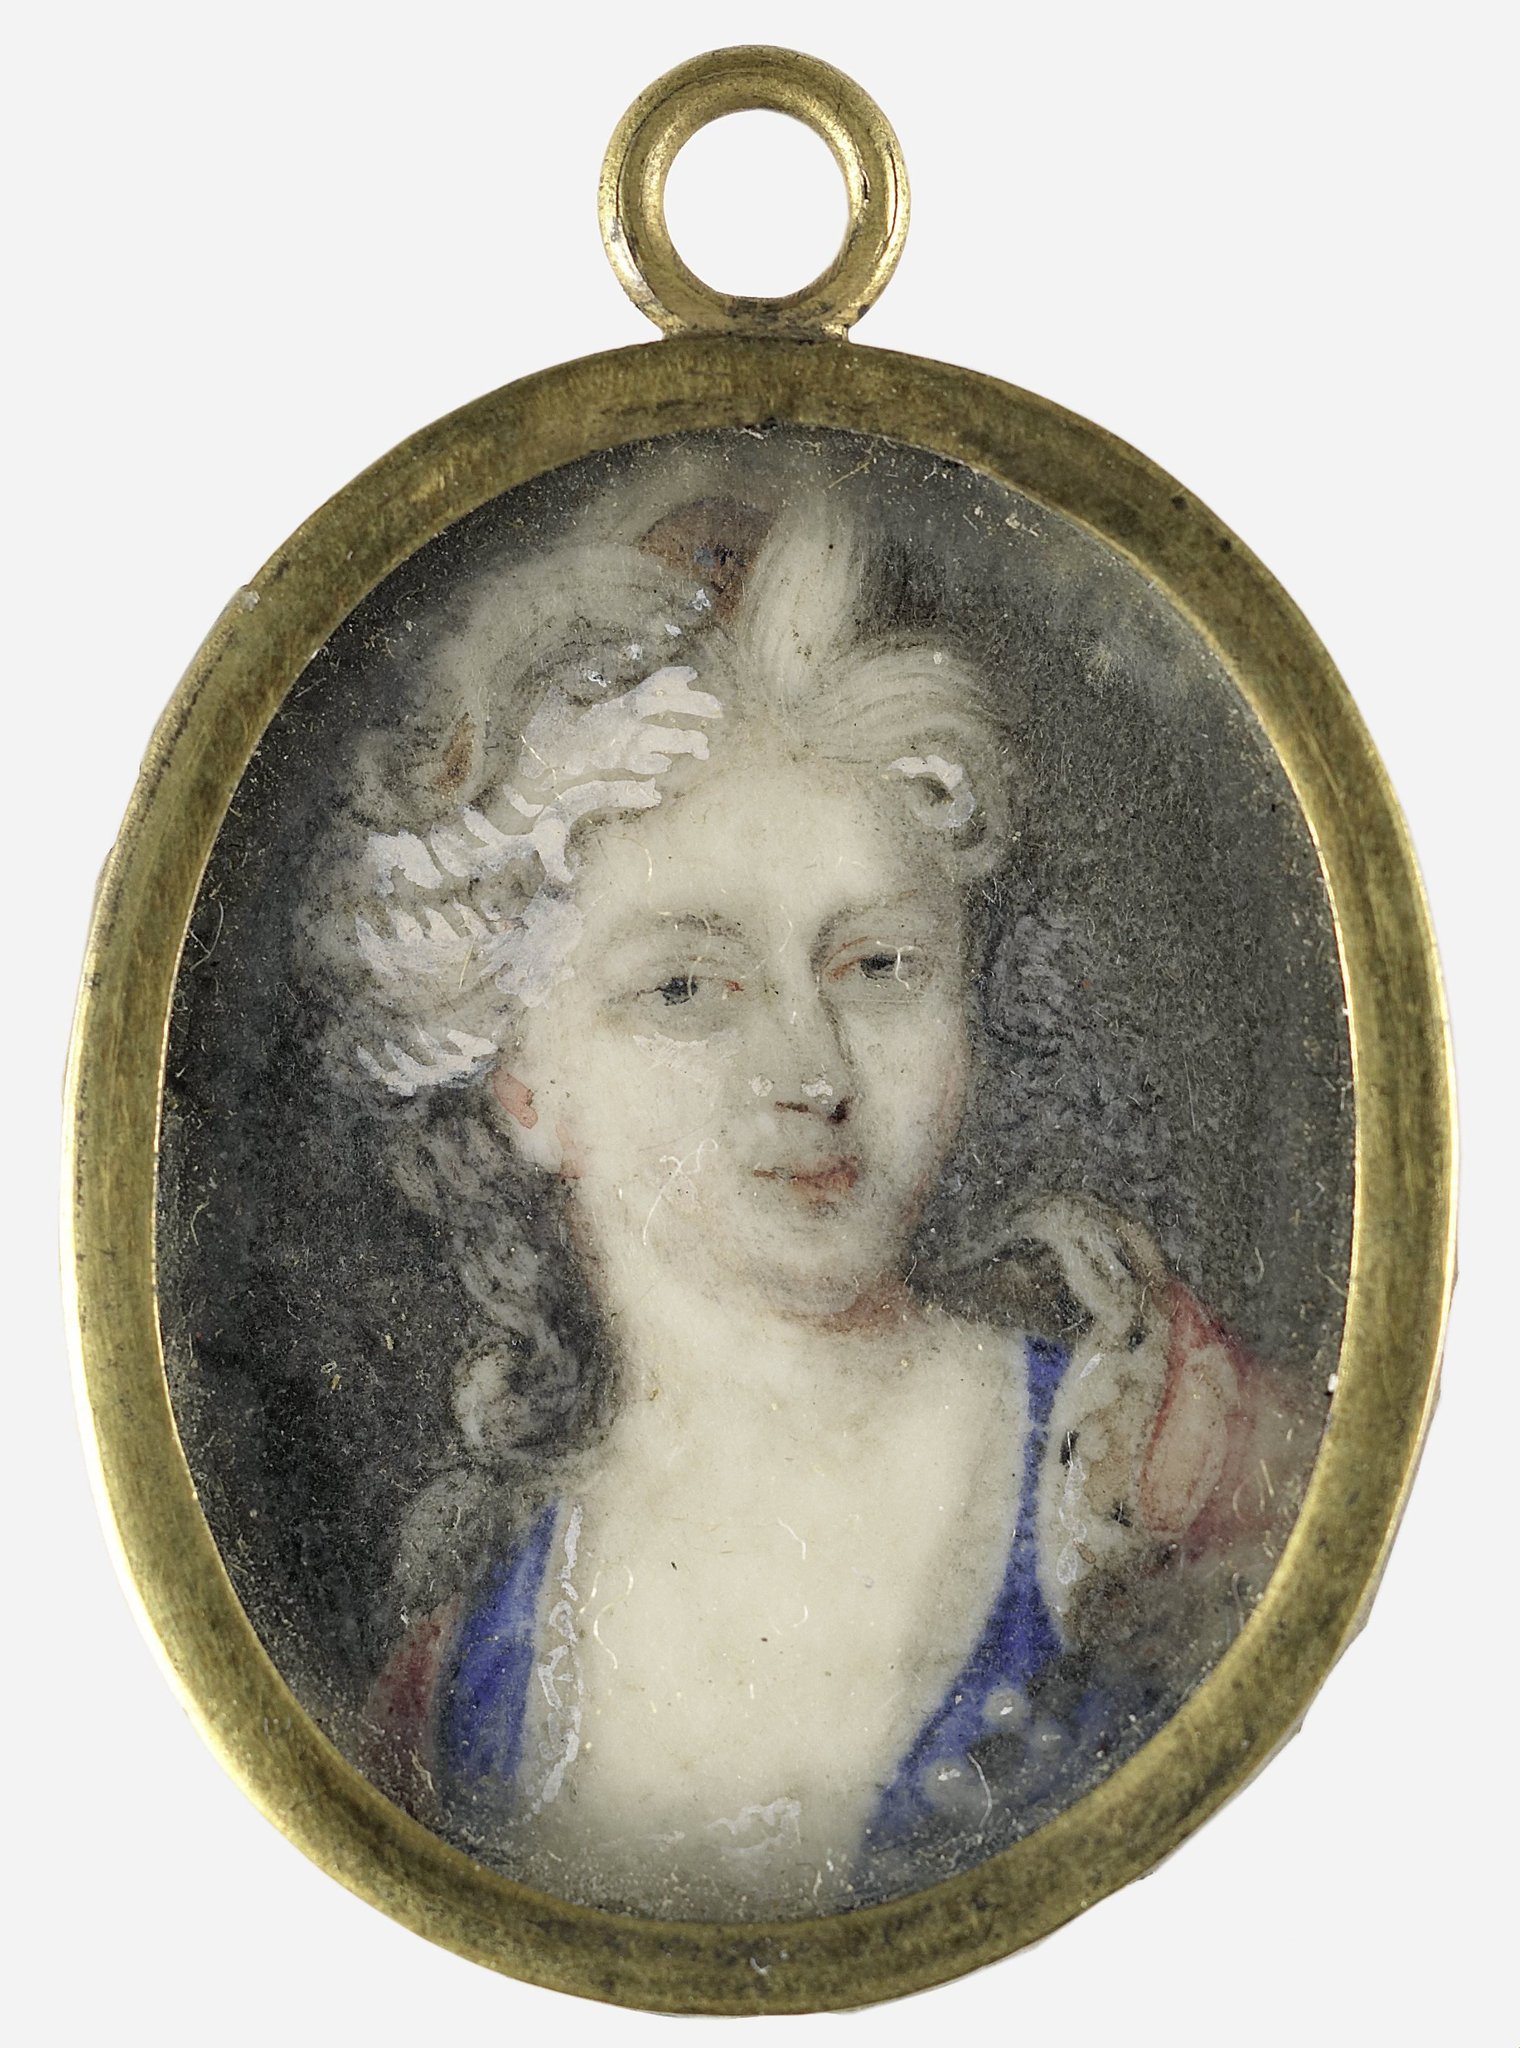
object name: painting, miniature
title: Portret van een vrouw, vermoedelijk Christiane Charlotte van Württemberg (1694-1729)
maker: Anonymous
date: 1710-1730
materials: glass, ivory, metal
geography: germany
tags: christiane charlotte von württemberg-winnental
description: Portret van een vrouw, vermoedelijk Christiane Charlotte van Württemberg (1694-1729). Buste, aanziend. Onderdeel van de collectie portretminiaturen.